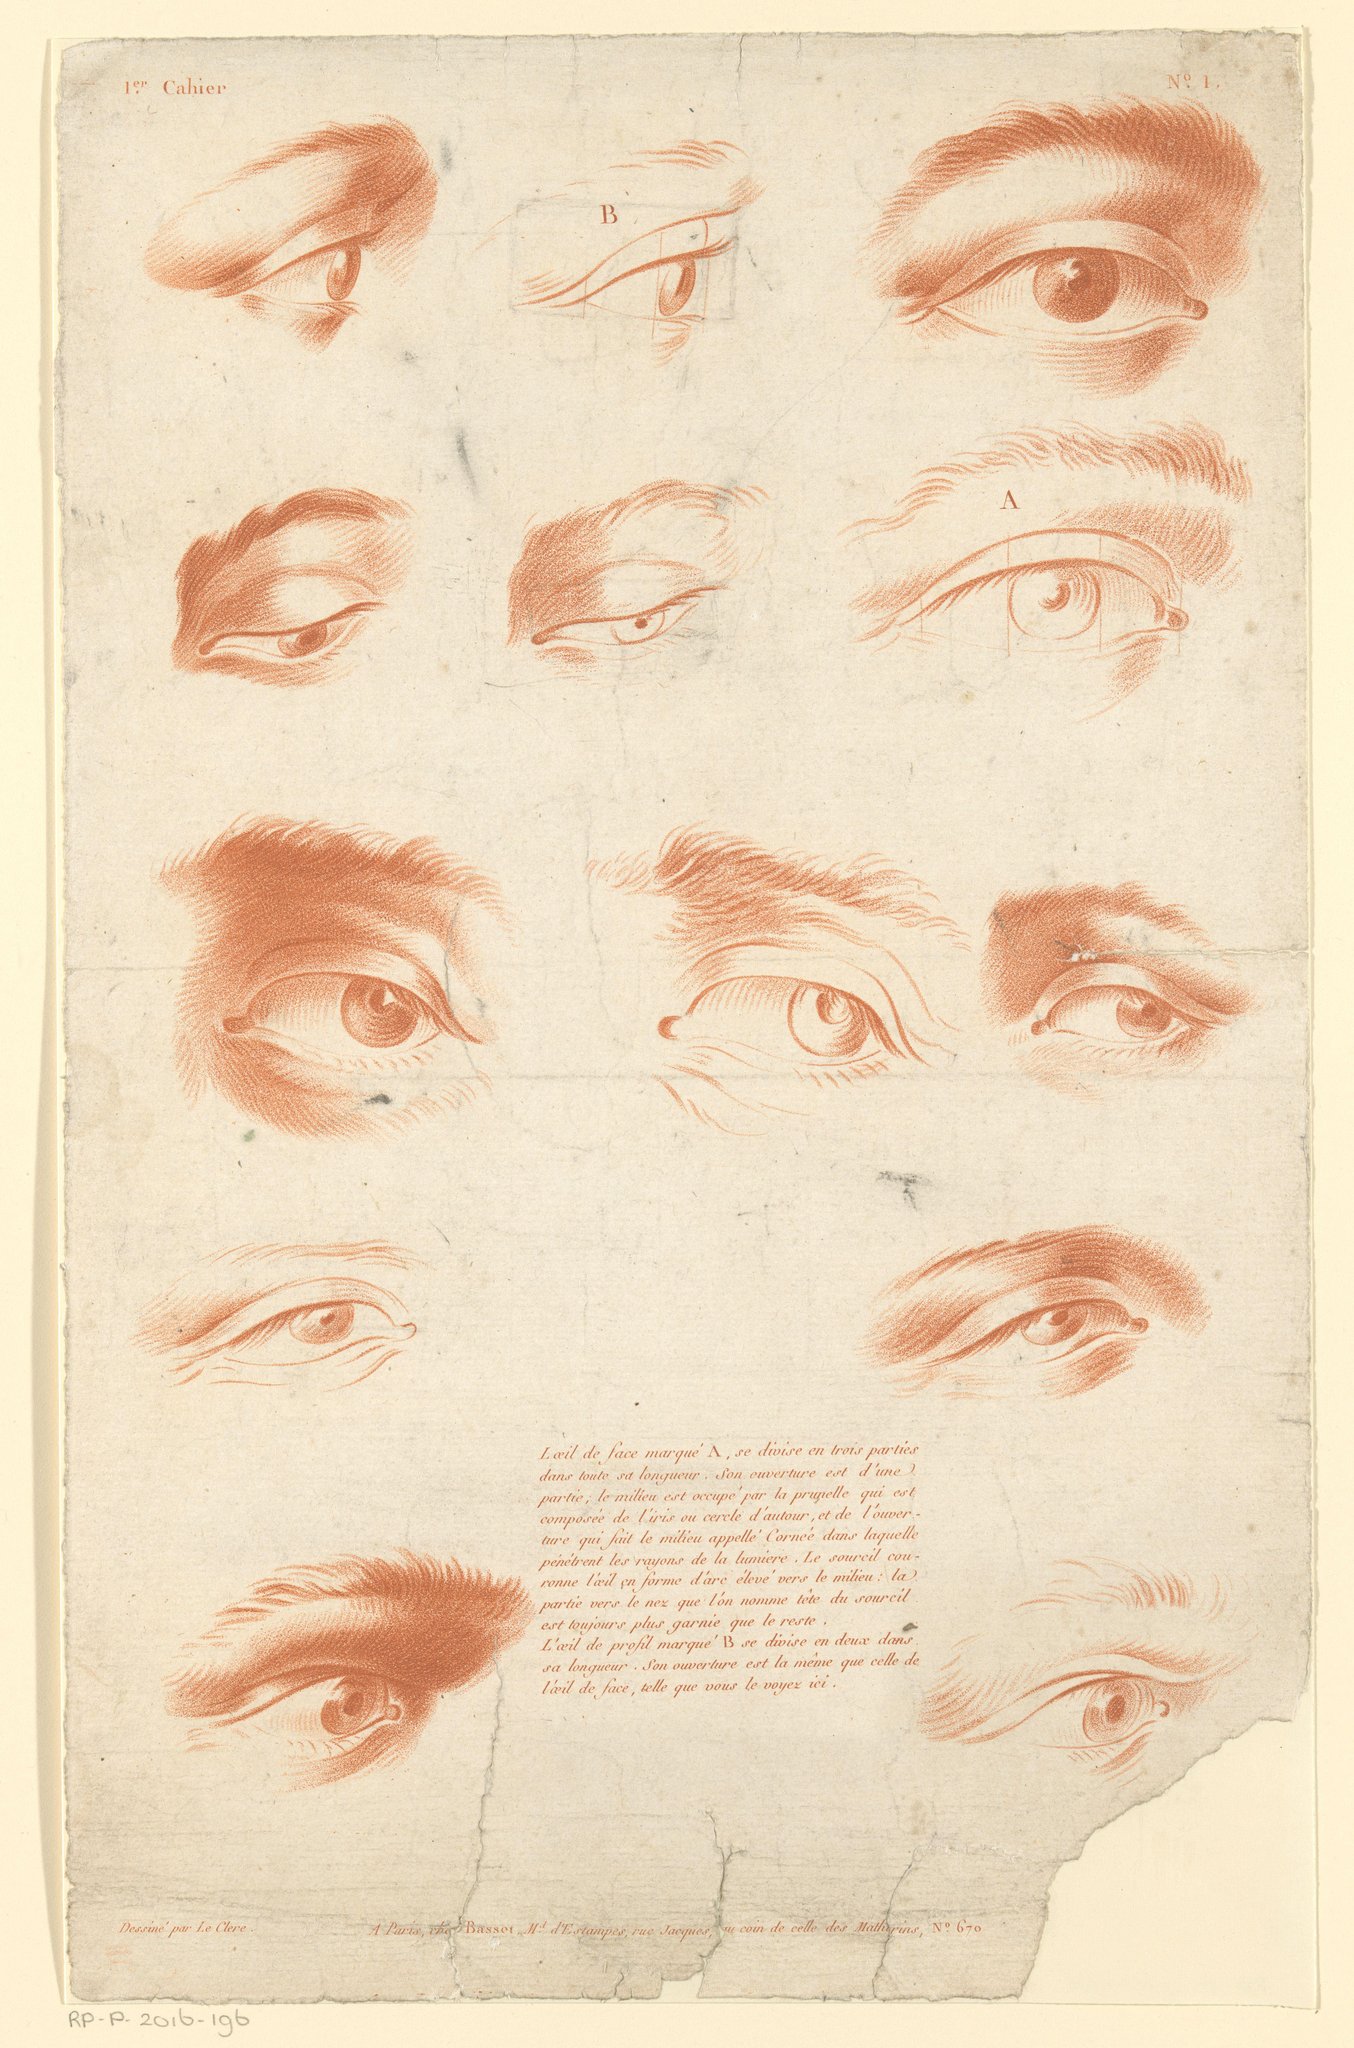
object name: tekenvoorbeeld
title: Dertien studies van ogen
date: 1795-1819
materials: paper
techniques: printmaking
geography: paris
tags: drawing, sketch, eyes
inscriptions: collector's mark: Lugt 2228